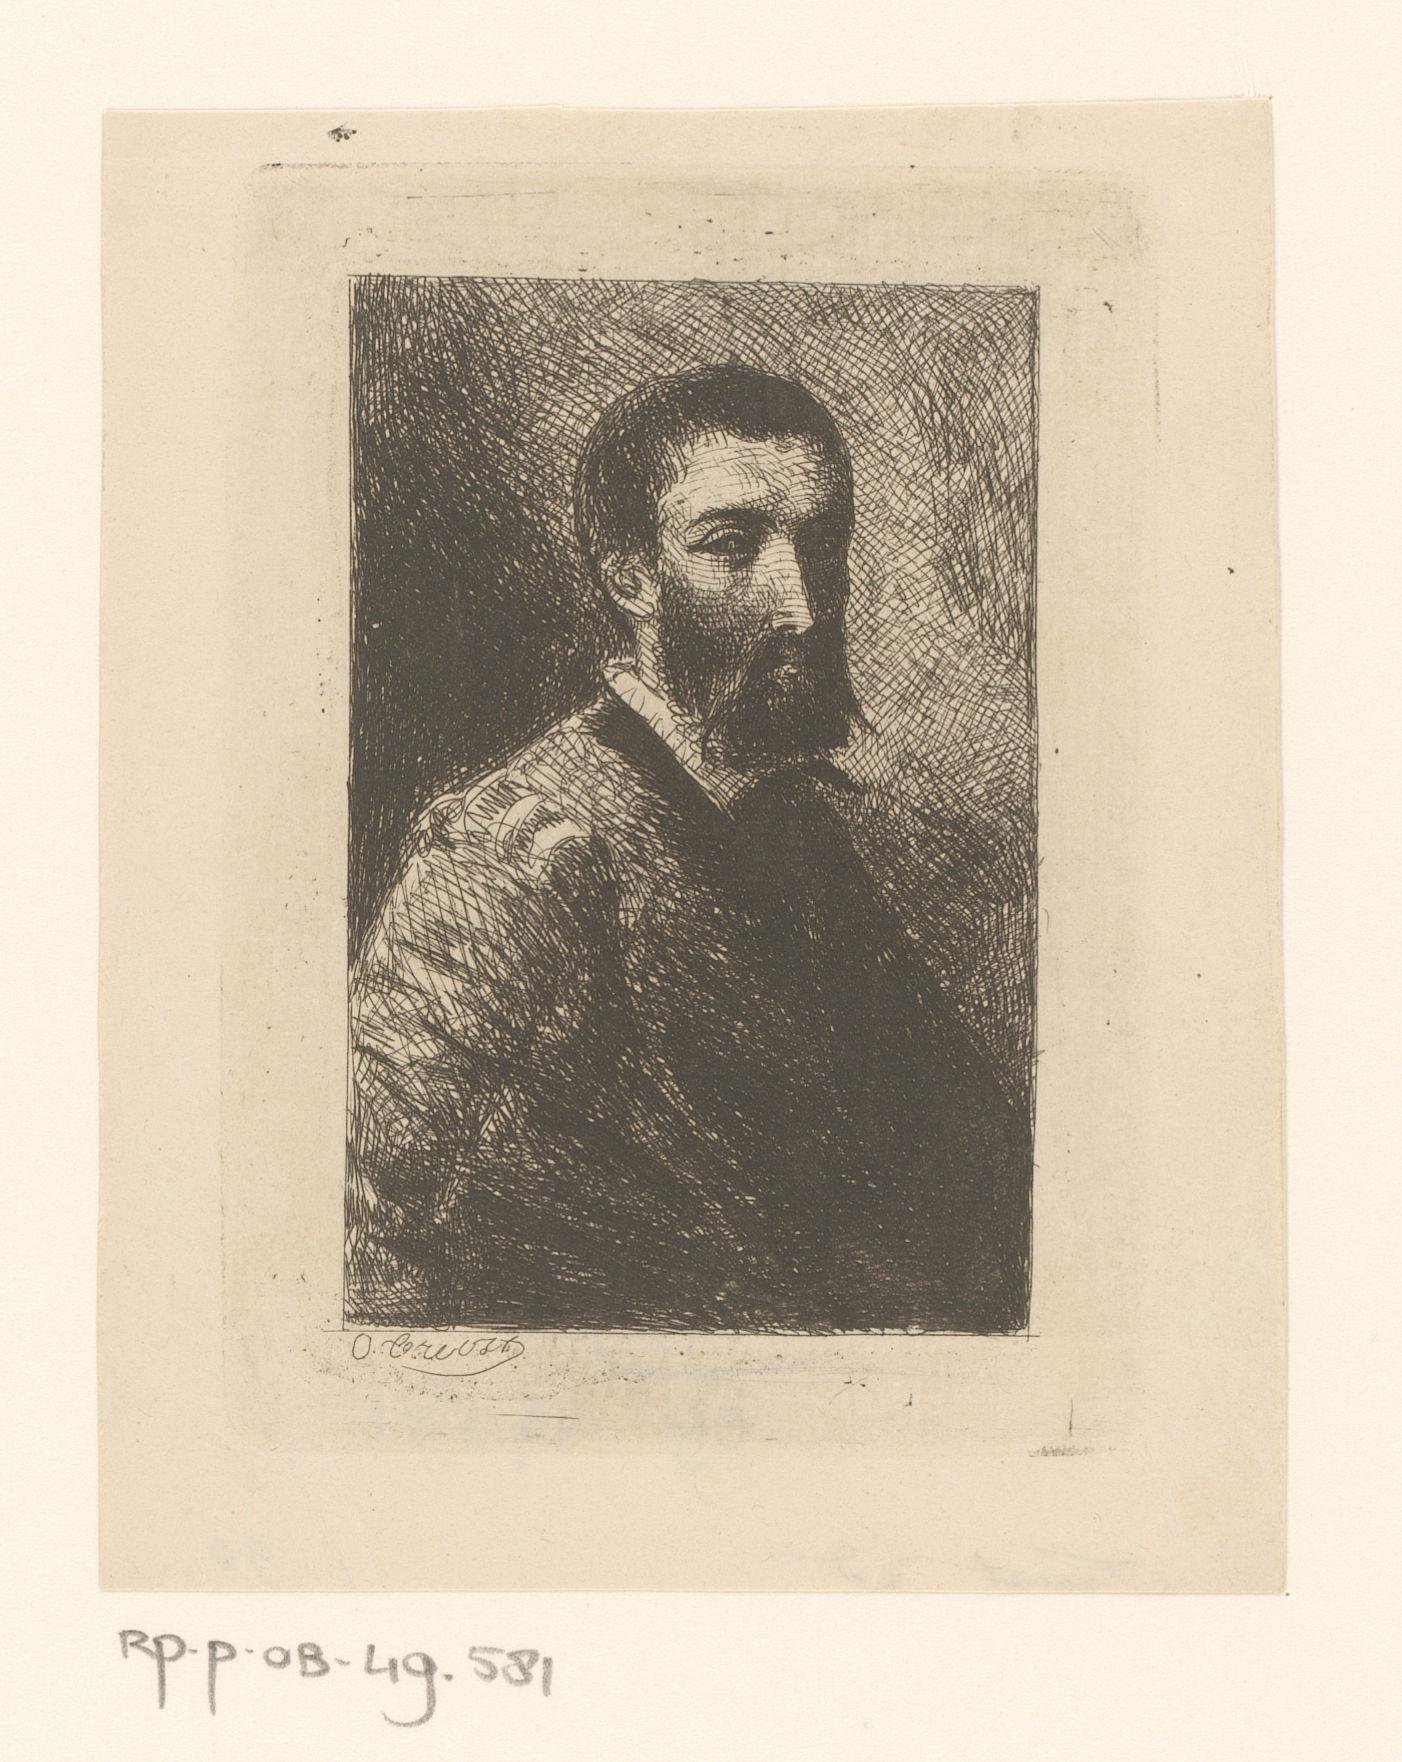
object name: print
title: Zelfportret van Odulf Troost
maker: odulf troost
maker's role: print maker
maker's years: 1820-1854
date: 1830-1854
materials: paper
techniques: etching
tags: hoegaarden, antwerp, print maker, odulf troost, portrait, self-portrait of painter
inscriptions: collector's mark: Lugt 2228